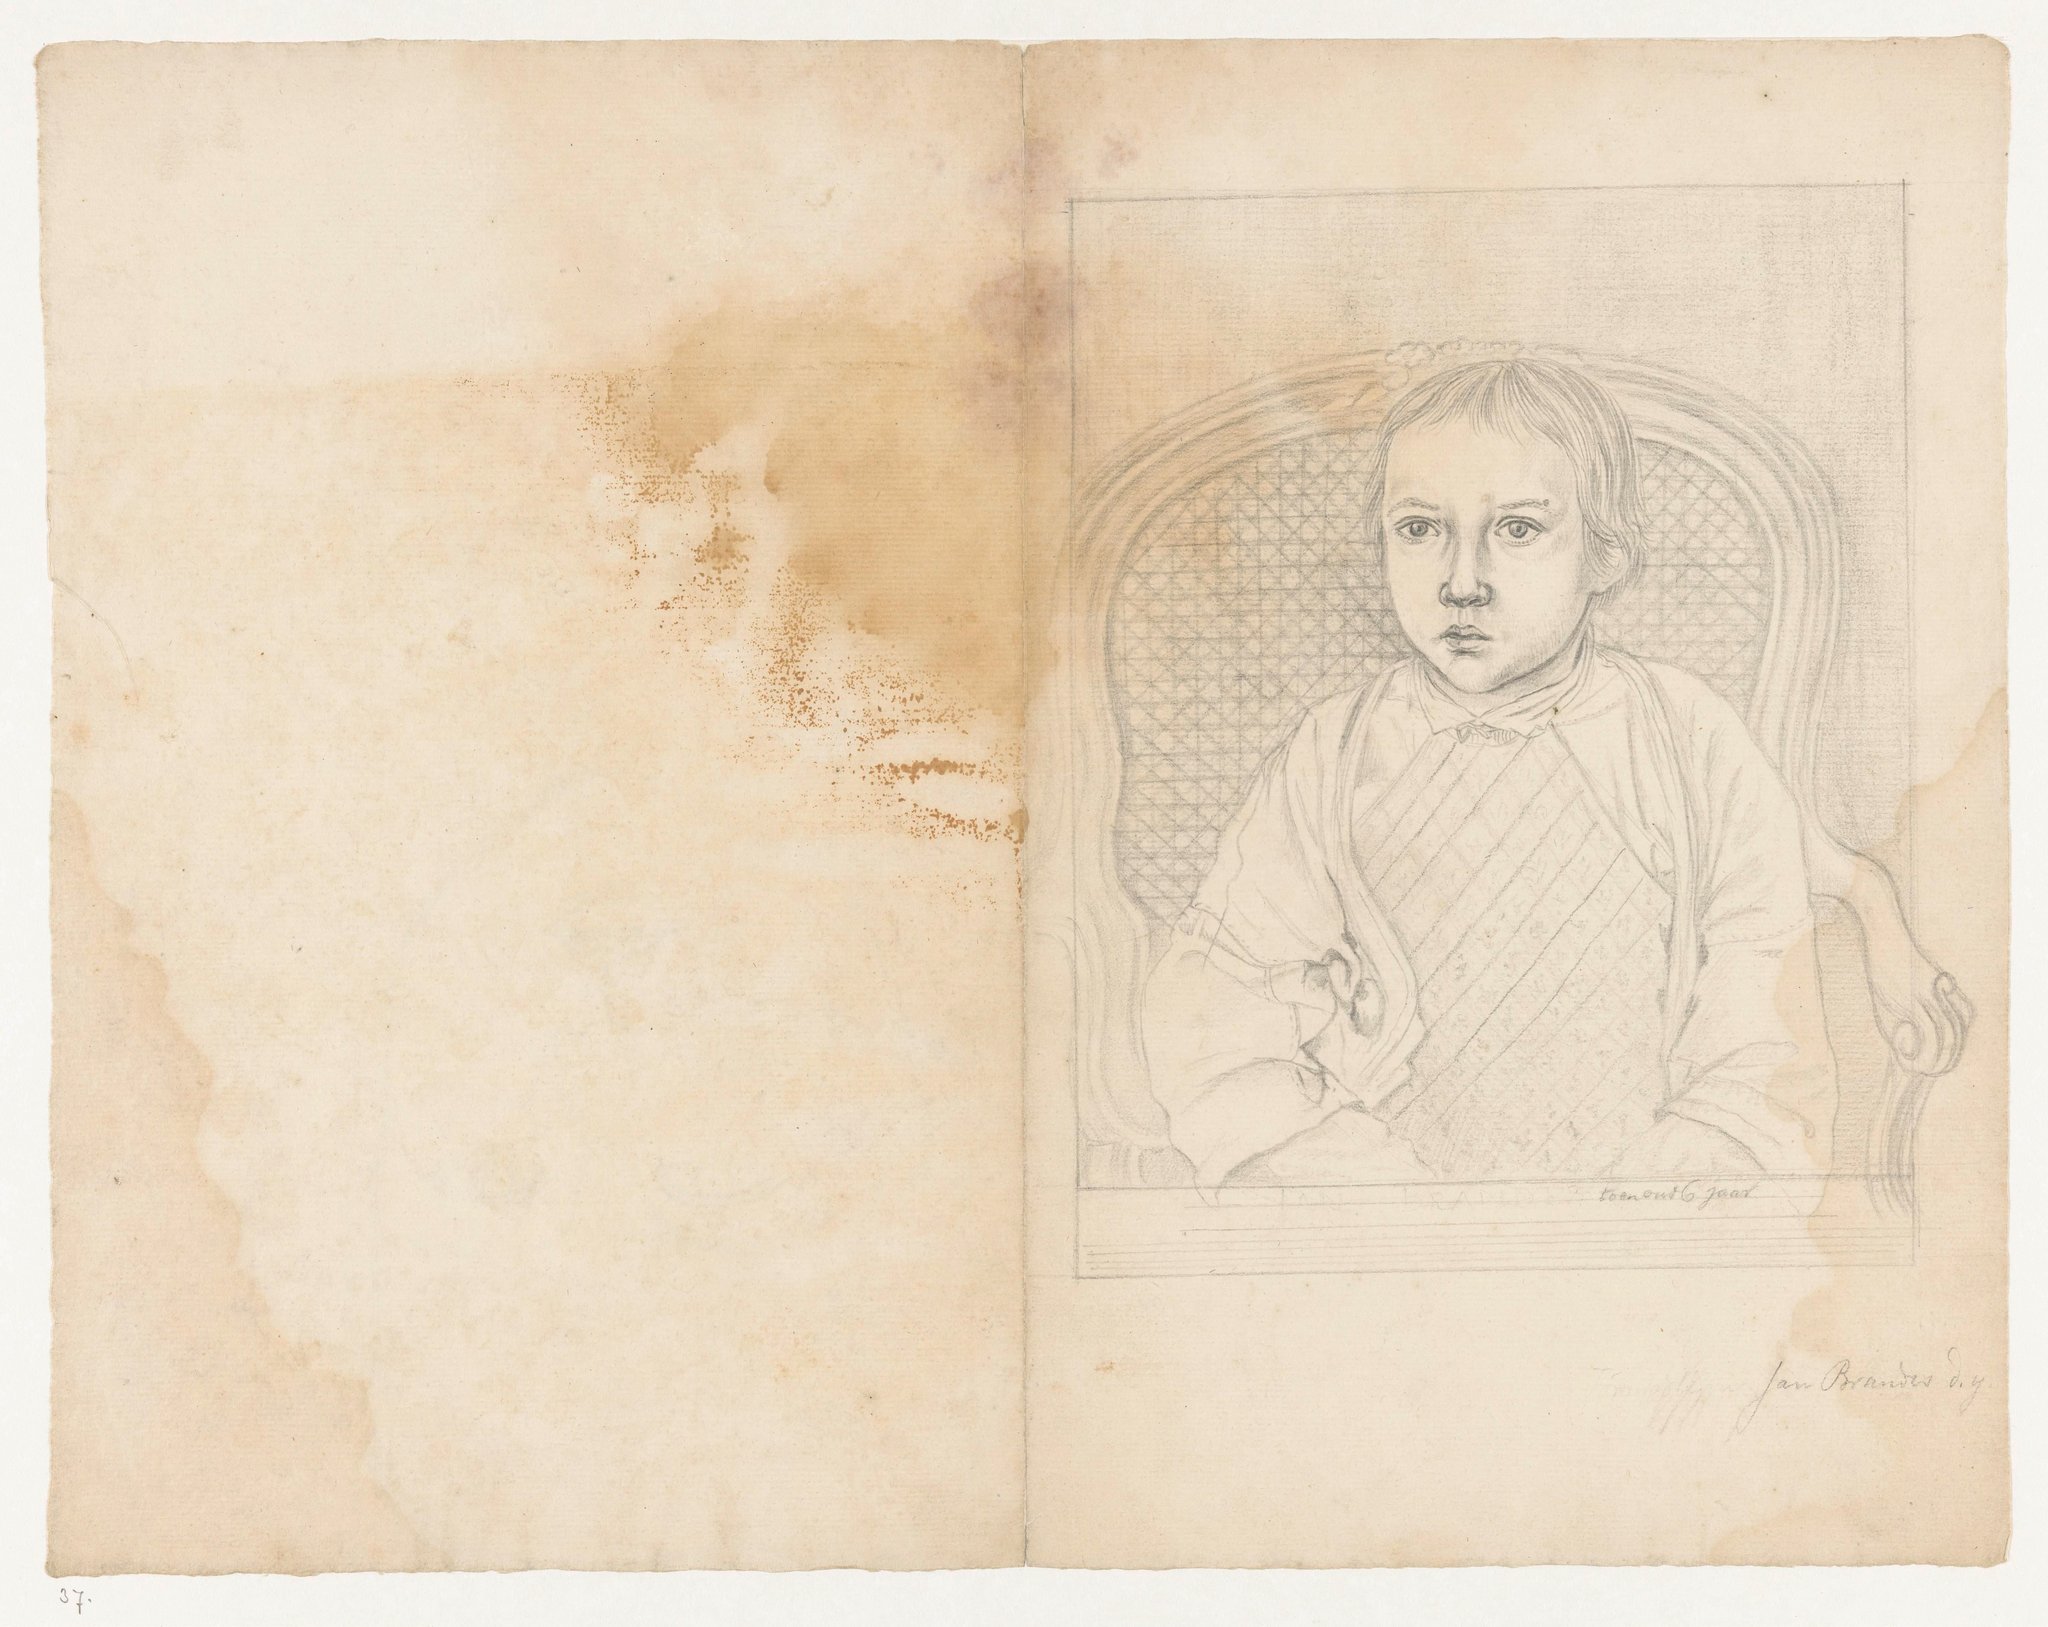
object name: drawing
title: Jantje in een stoel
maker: jan brandes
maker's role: draughtsman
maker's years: 1743-1808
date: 1785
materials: paper, pencil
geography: batavia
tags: historical persons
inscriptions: inscription: ‘toen oud 6 jaar / Jan Brandes d.y.’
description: Portret van Jantje Brandes, de zoon van Jan Brandes, zes jaar oud, zittend in een stoel. Op het verso enkele schetsen van gelaat van Jantje. Met opschrift.